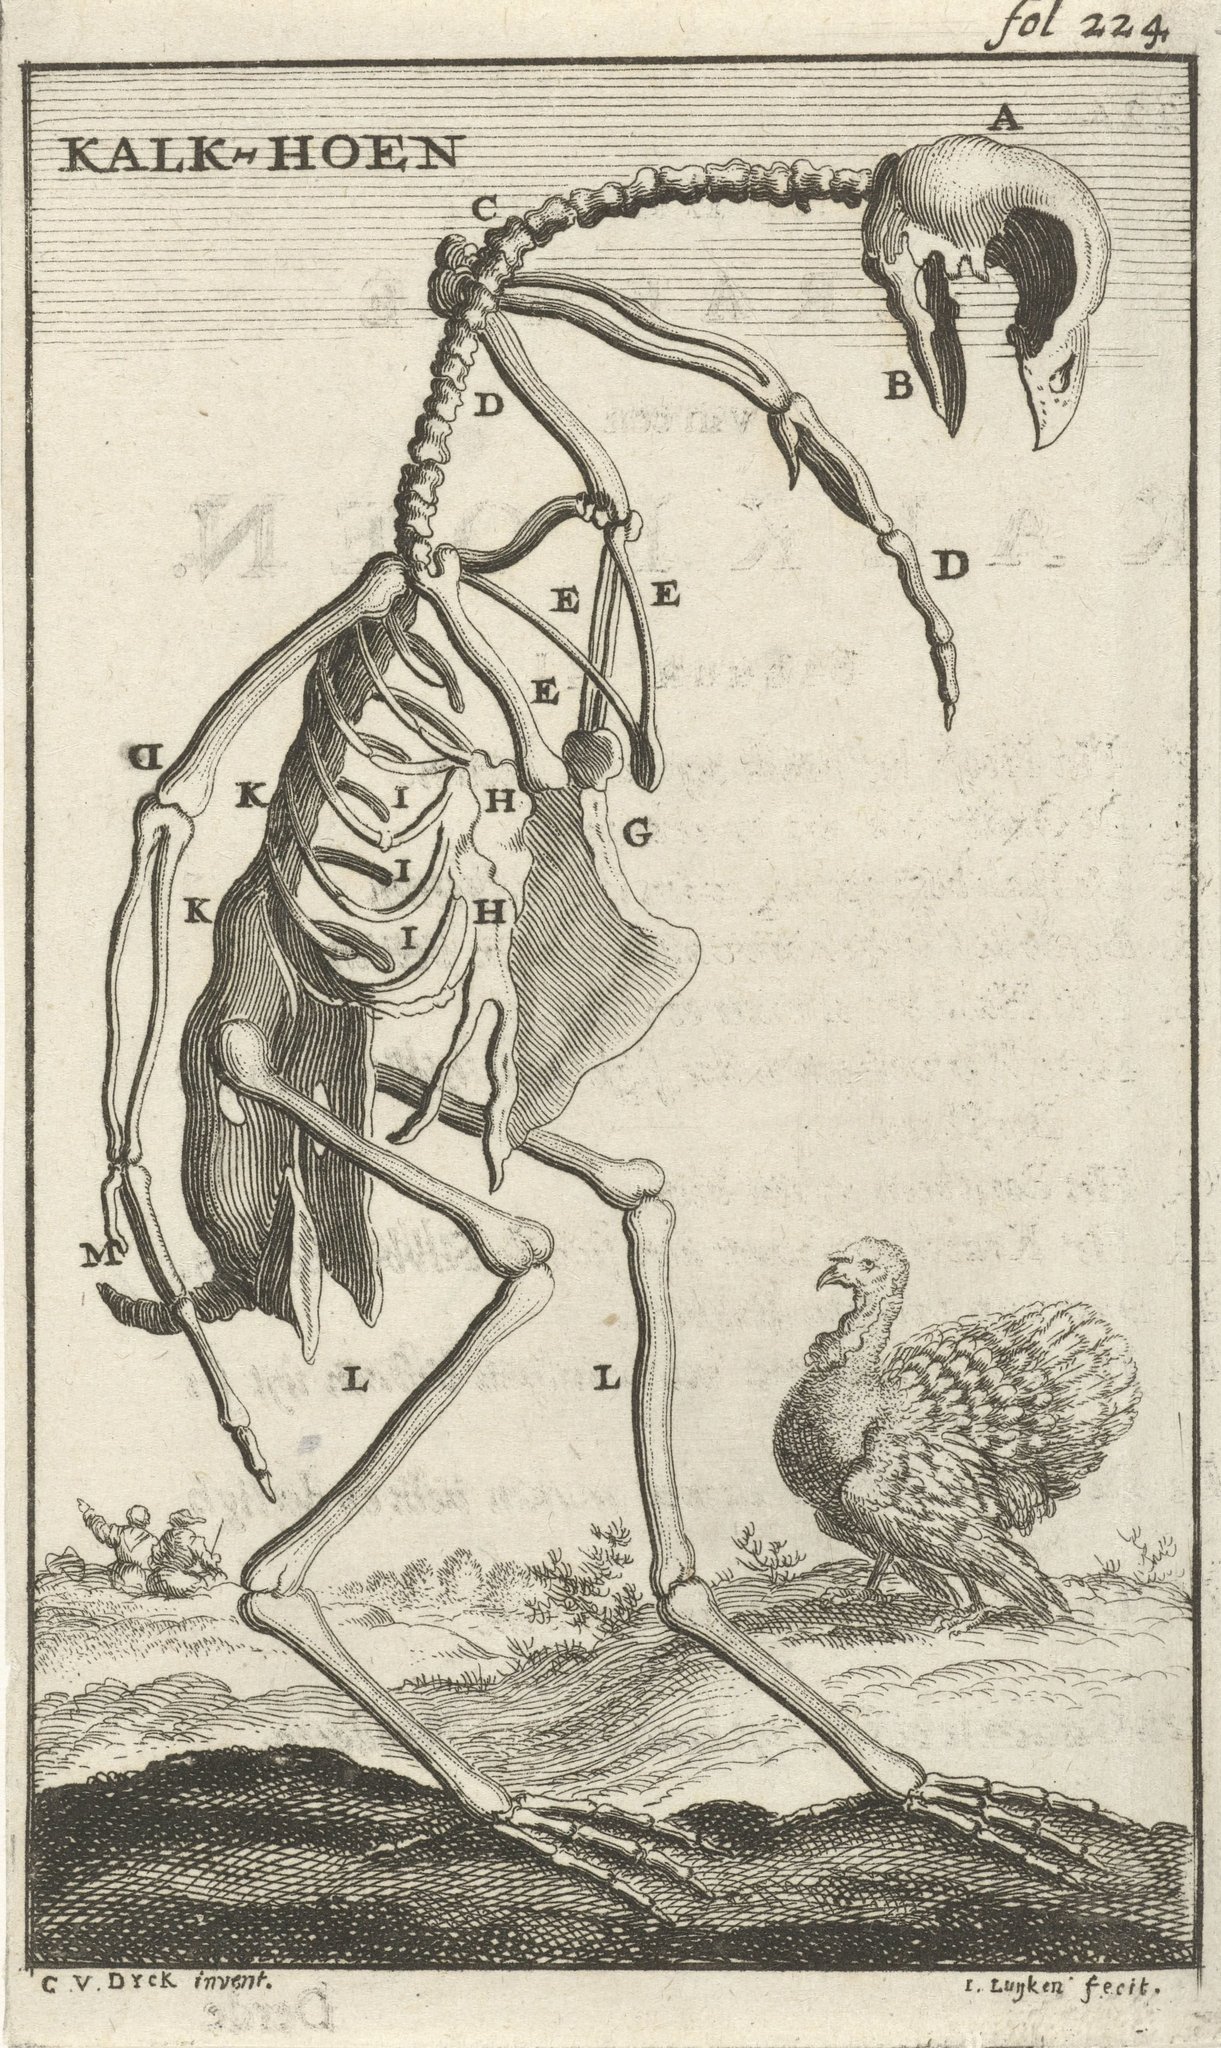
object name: print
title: Kalk-Hoen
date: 1680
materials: paper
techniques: etching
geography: amsterdam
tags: animals (+ skeleton of an animal), walker and runner birds: turkey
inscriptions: collector's mark: Lugt 2228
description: Illustratie opgenomen in: Dyk, Cornelis van. Osteologia, of nauwkeurige geraamt beschryving van verscheyde dieren, nevens hare historien. Amsterdam: Jan Claesz ten Hoorn, 1680.